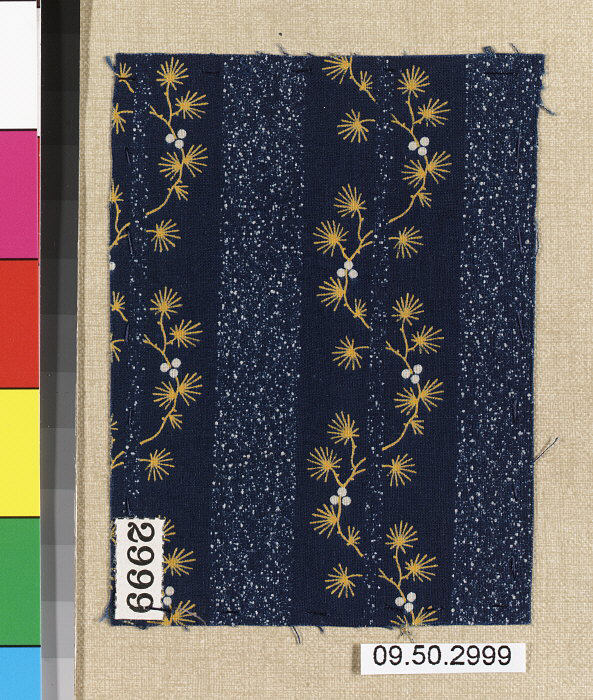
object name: piece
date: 1801-1900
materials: cotton